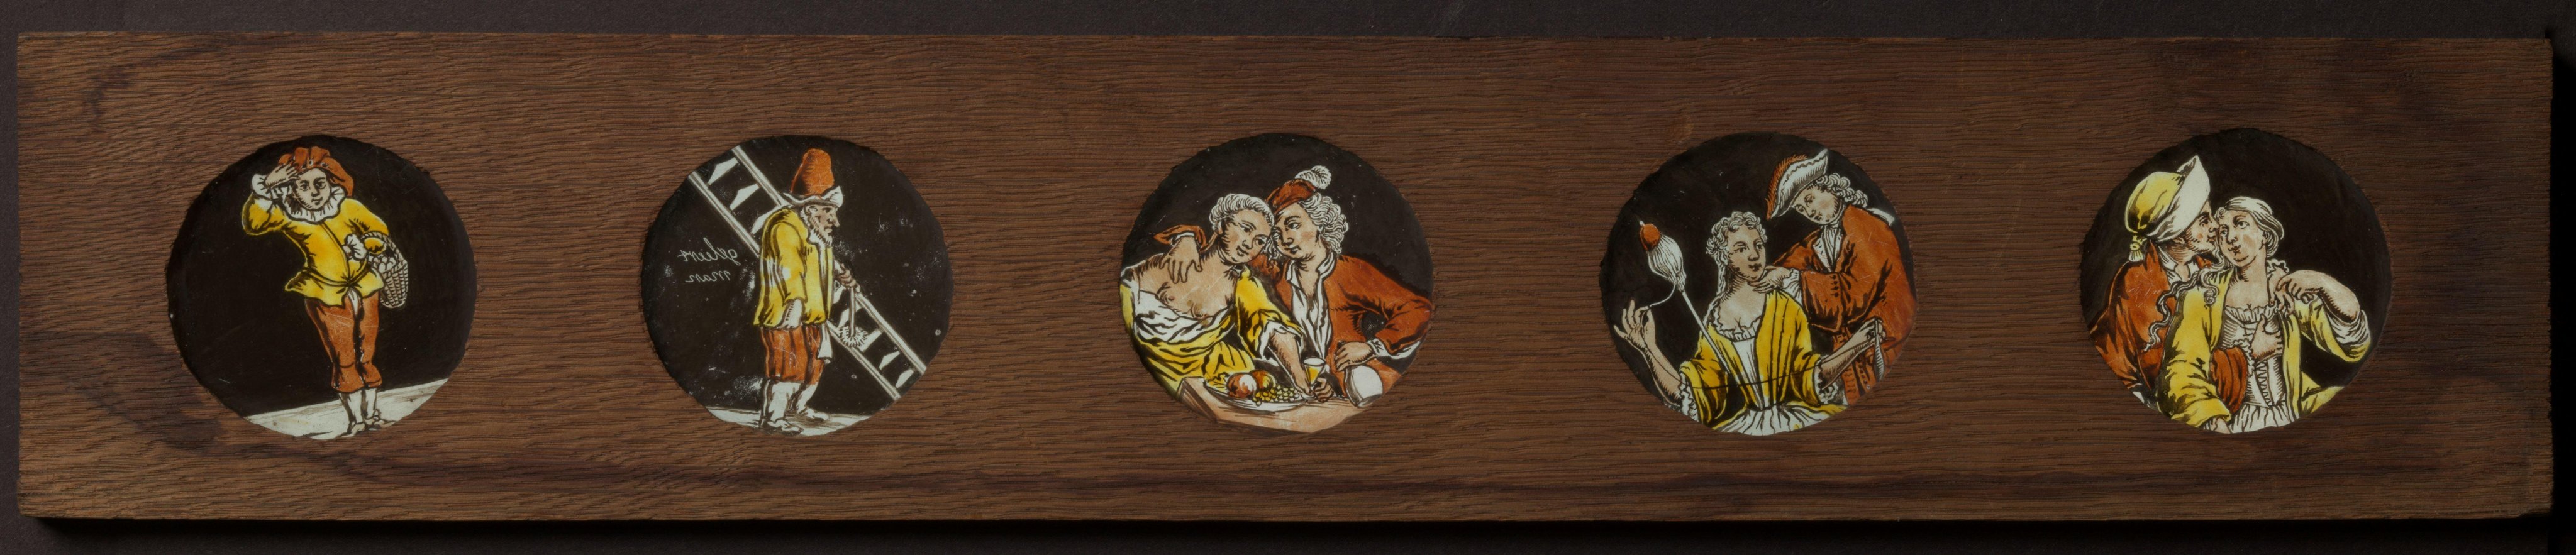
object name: lantern slide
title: Vijf afbeeldingen van mannen -en vrouwenpersonen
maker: Anonymous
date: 1720-1750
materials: glass, wood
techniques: enamel painting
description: Houten frame met vijf ronde glasplaten, gebruikt voor toverlantaarn. Vijf afbeeldingen van mannen -en vrouwenpersonen links: een man en een vrouw. De man omvat met zijn rechterhand de linkerborst van de vrouw. 2e van links: een vrouw is garen aan het spinnen, een man staat naast haar en liefkoost haar gezicht. midden:een man en een vrouw zitten aan tafel. Hij schenkt wijn voor haar in en met de andere hand nijgt hij naar de ontblote borsten van de vrouw. Op tafel staat eten. 2e van rechts: 'geleerd man'. Een man, lijkt wel op een kabouter, heeft een ladder in zijn rechterhand. rechts: een mannetje met een geel jasje en een rode broek met petje heeft een mandje gevuld met eieren in zijn linkerhand. Met zijn rechterhand nijgt hij naar zijn hoofd.